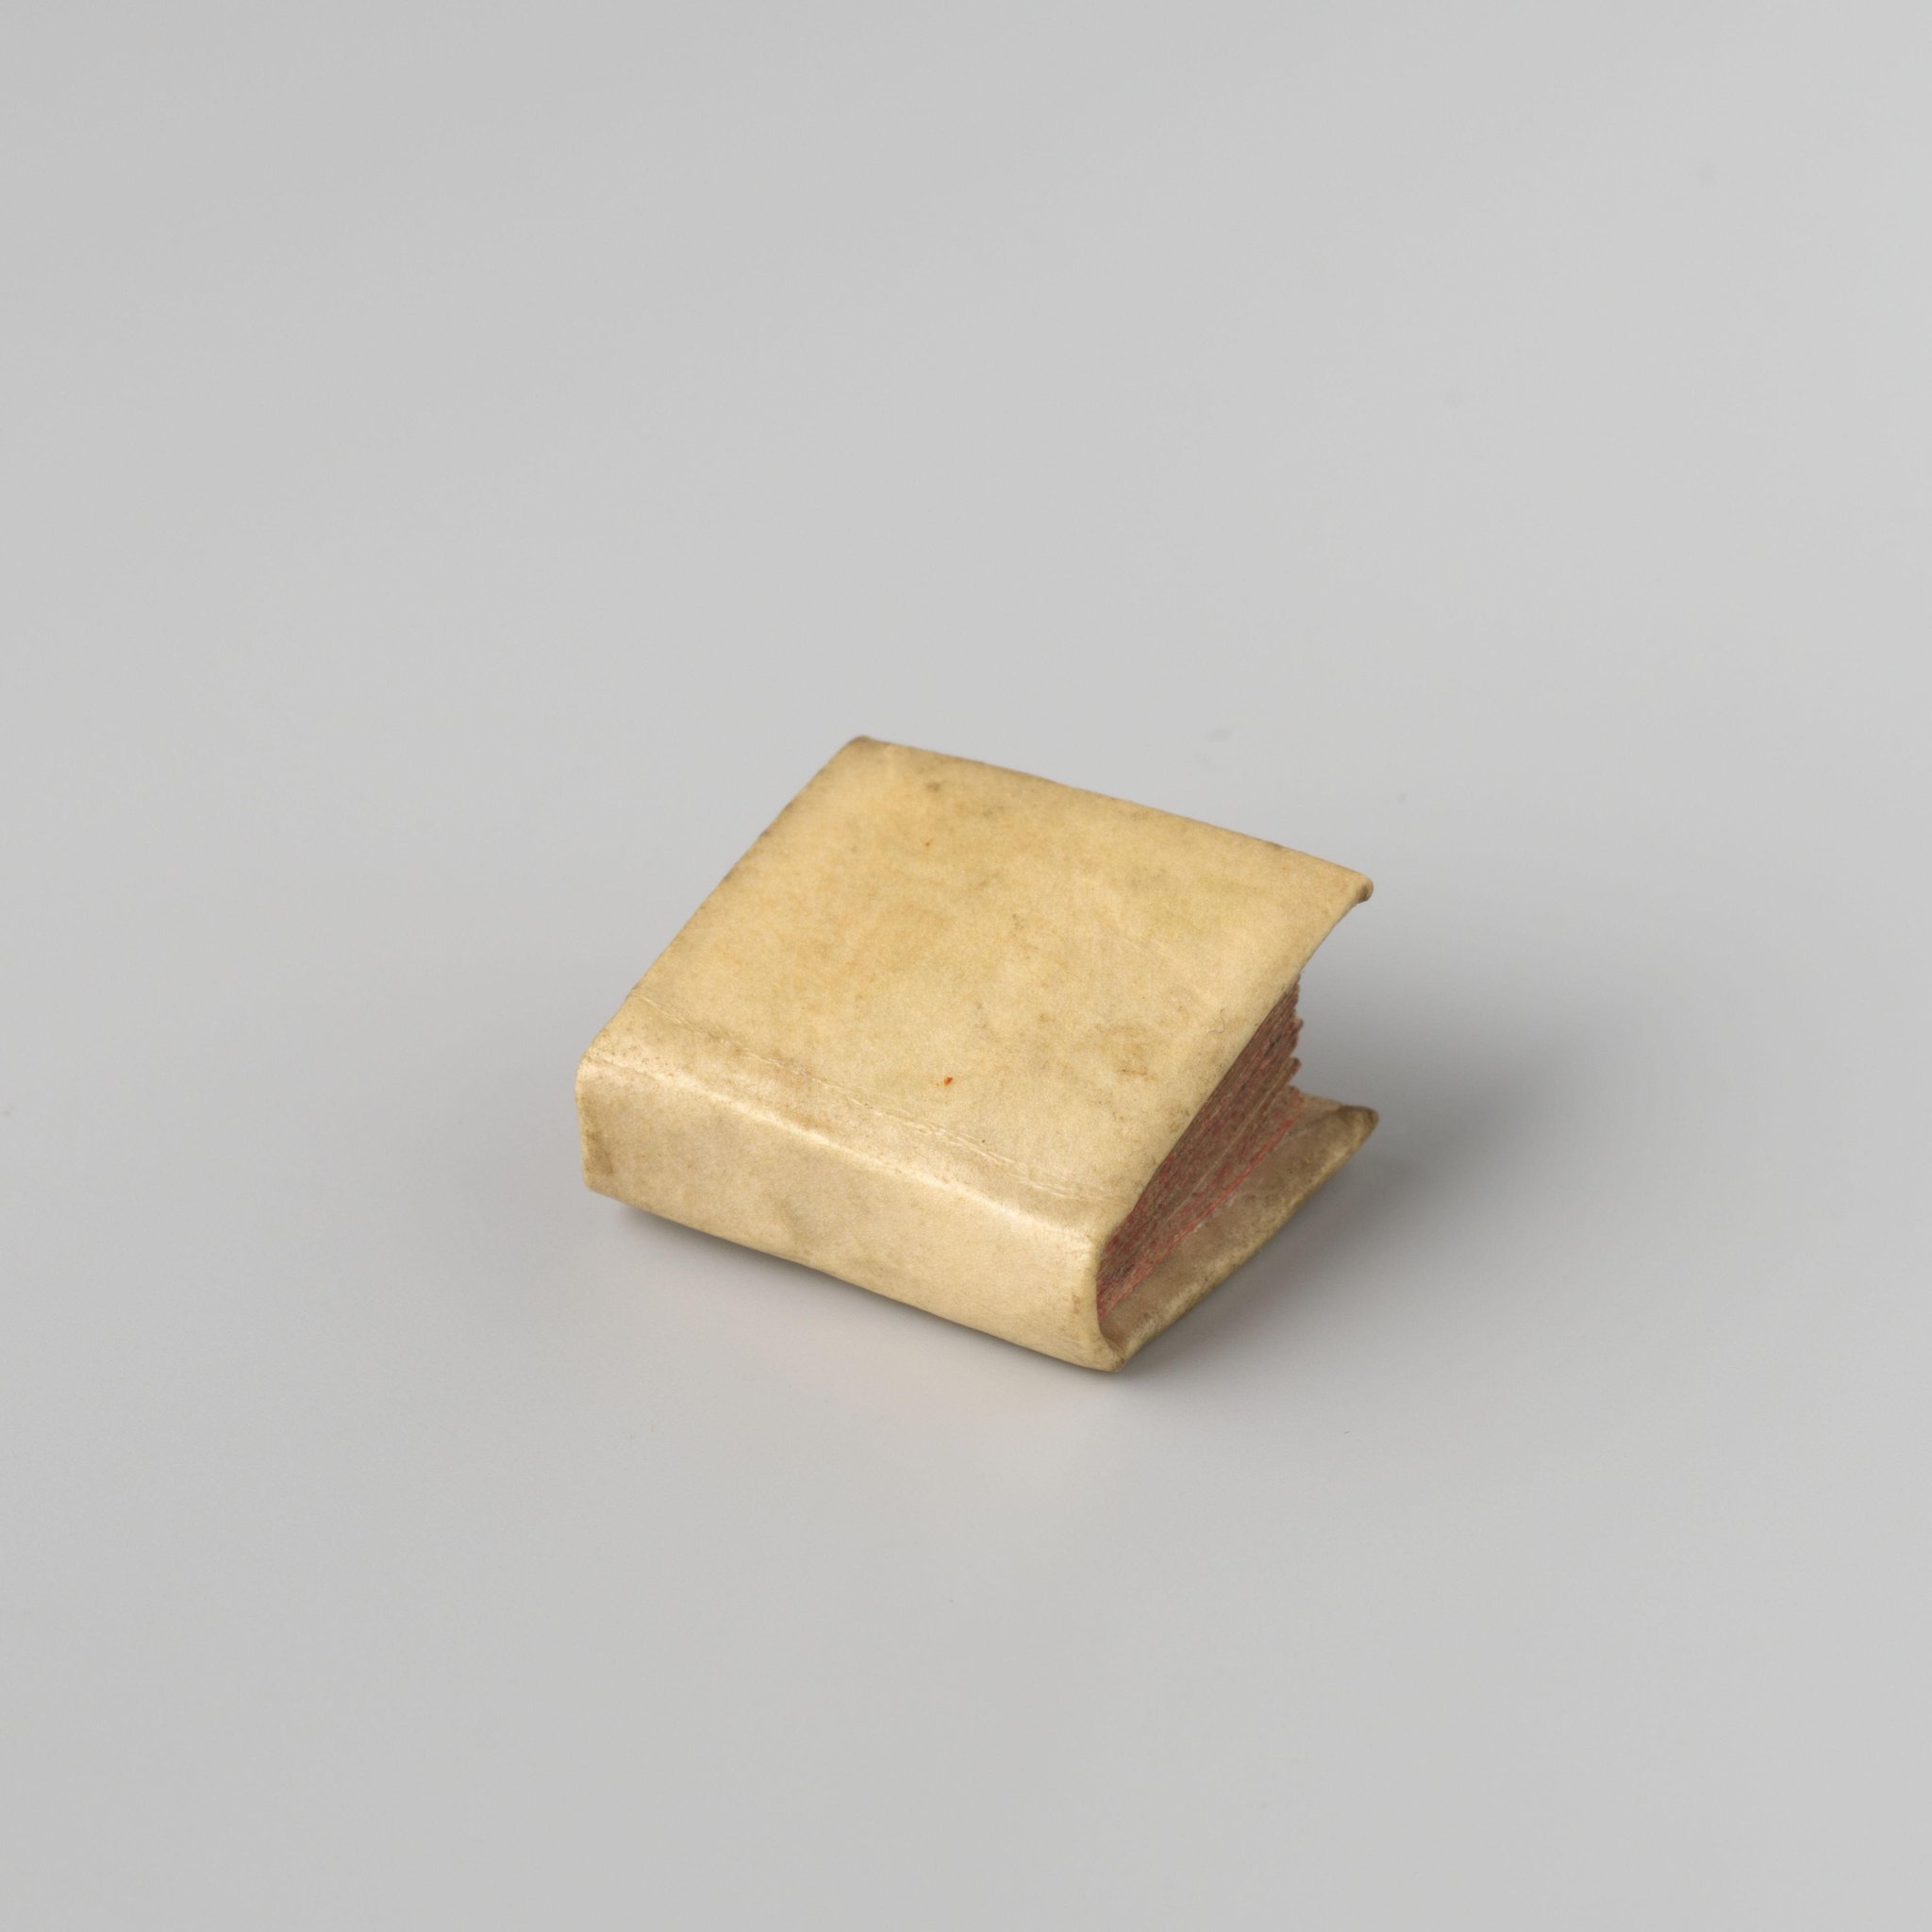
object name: book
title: Boek met figuren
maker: Anonymous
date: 1690-1710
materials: paper, parchment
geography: amsterdam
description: Boek met figuren. Ingebonden in blank perkament.